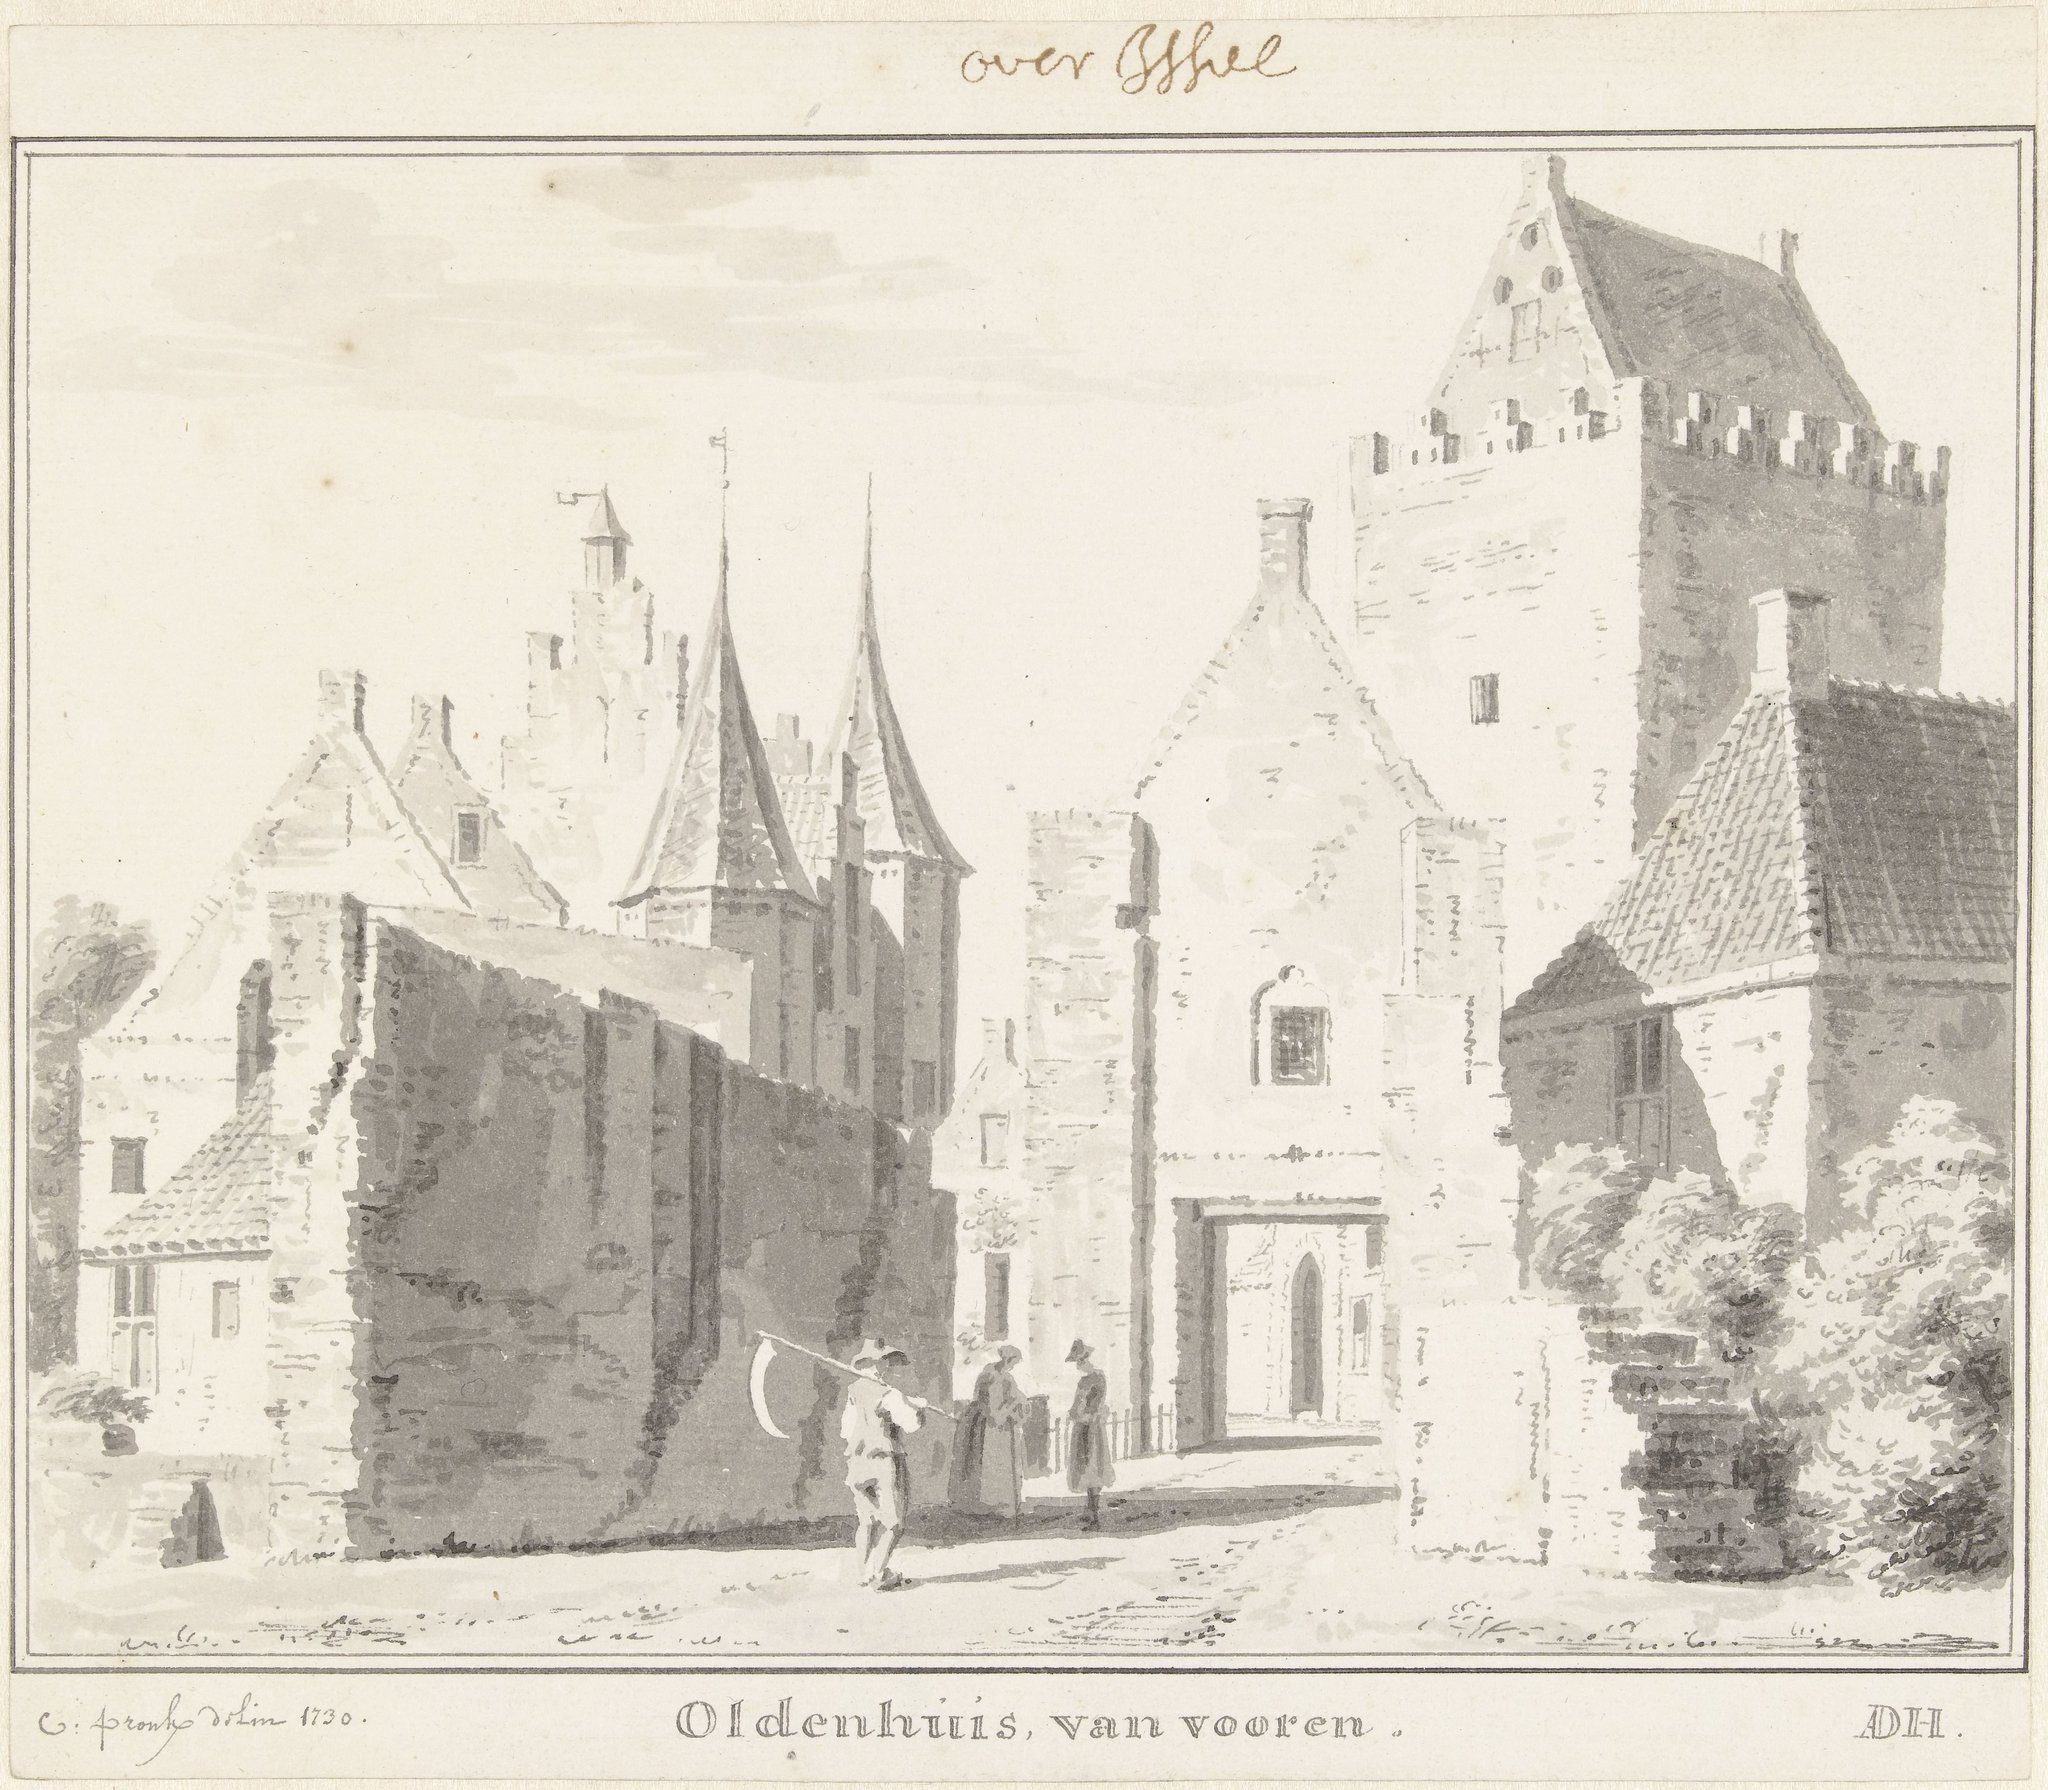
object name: drawing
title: Huis Oldenhuis te Vollenhove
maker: cornelis pronk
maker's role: draughtsman, painter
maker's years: 1691-1759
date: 1730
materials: ink, paper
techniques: brush, pen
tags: castle